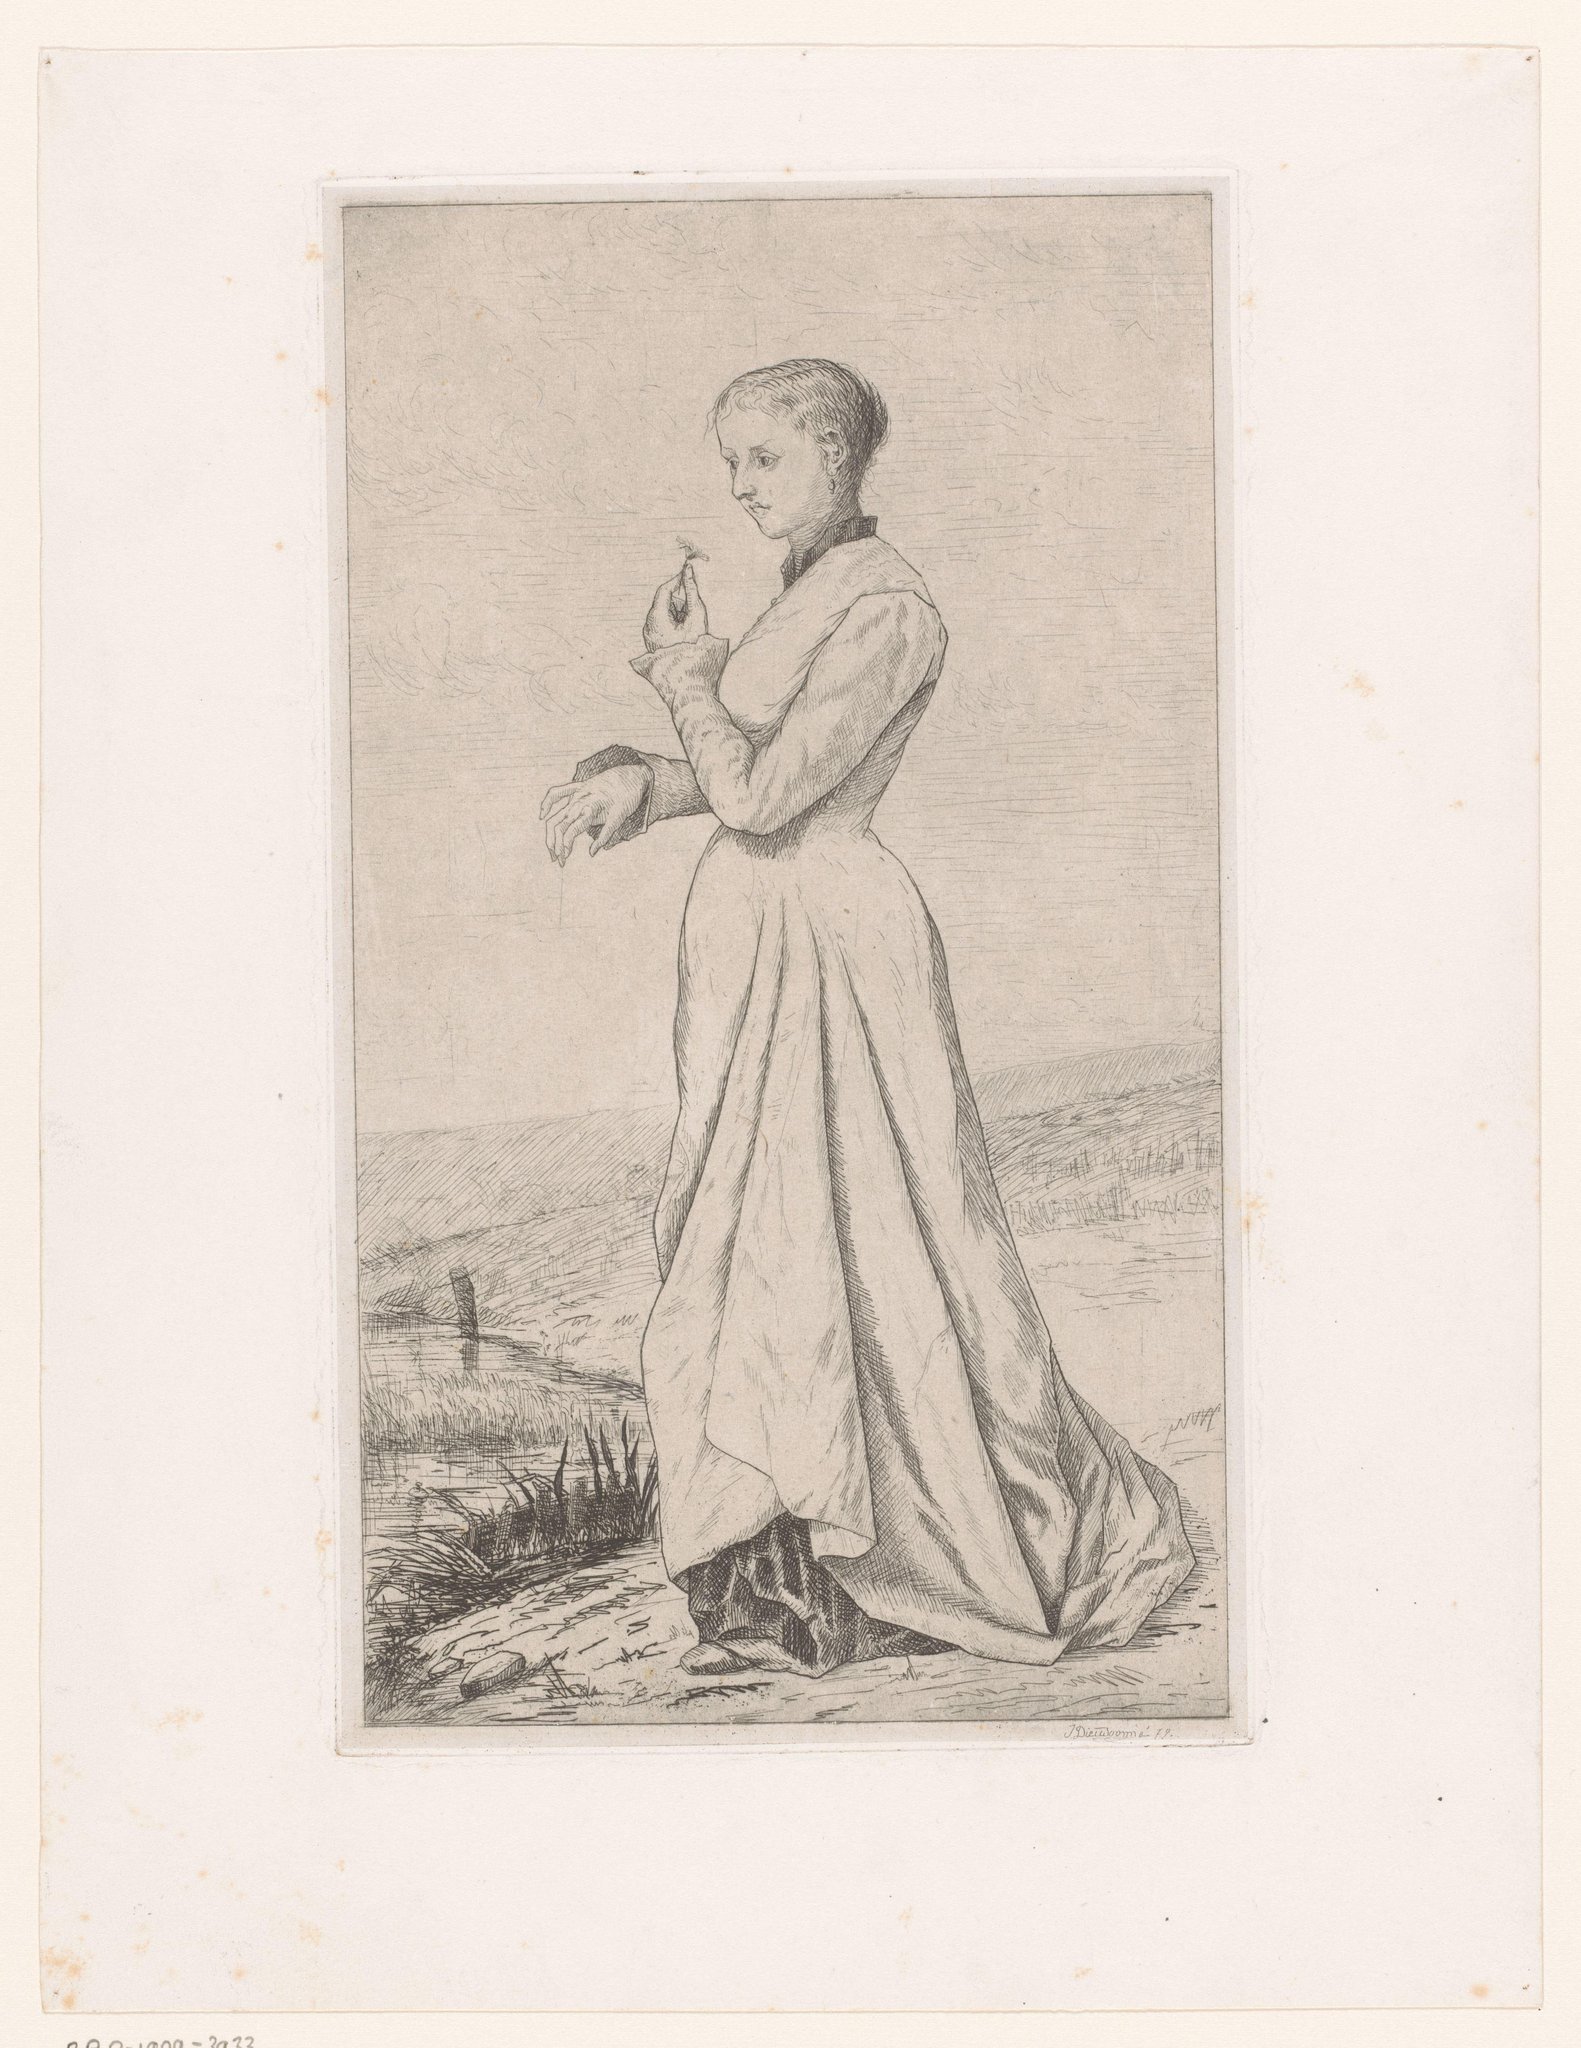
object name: print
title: Jonge vrouw raadpleegt een margriet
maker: jules dieudonné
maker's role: print maker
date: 1879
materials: paper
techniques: etching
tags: adolescent, young woman, maiden, flowers: daisy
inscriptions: inscription: ‘Le oracle des Champes’, collector's mark: Lugt 2228